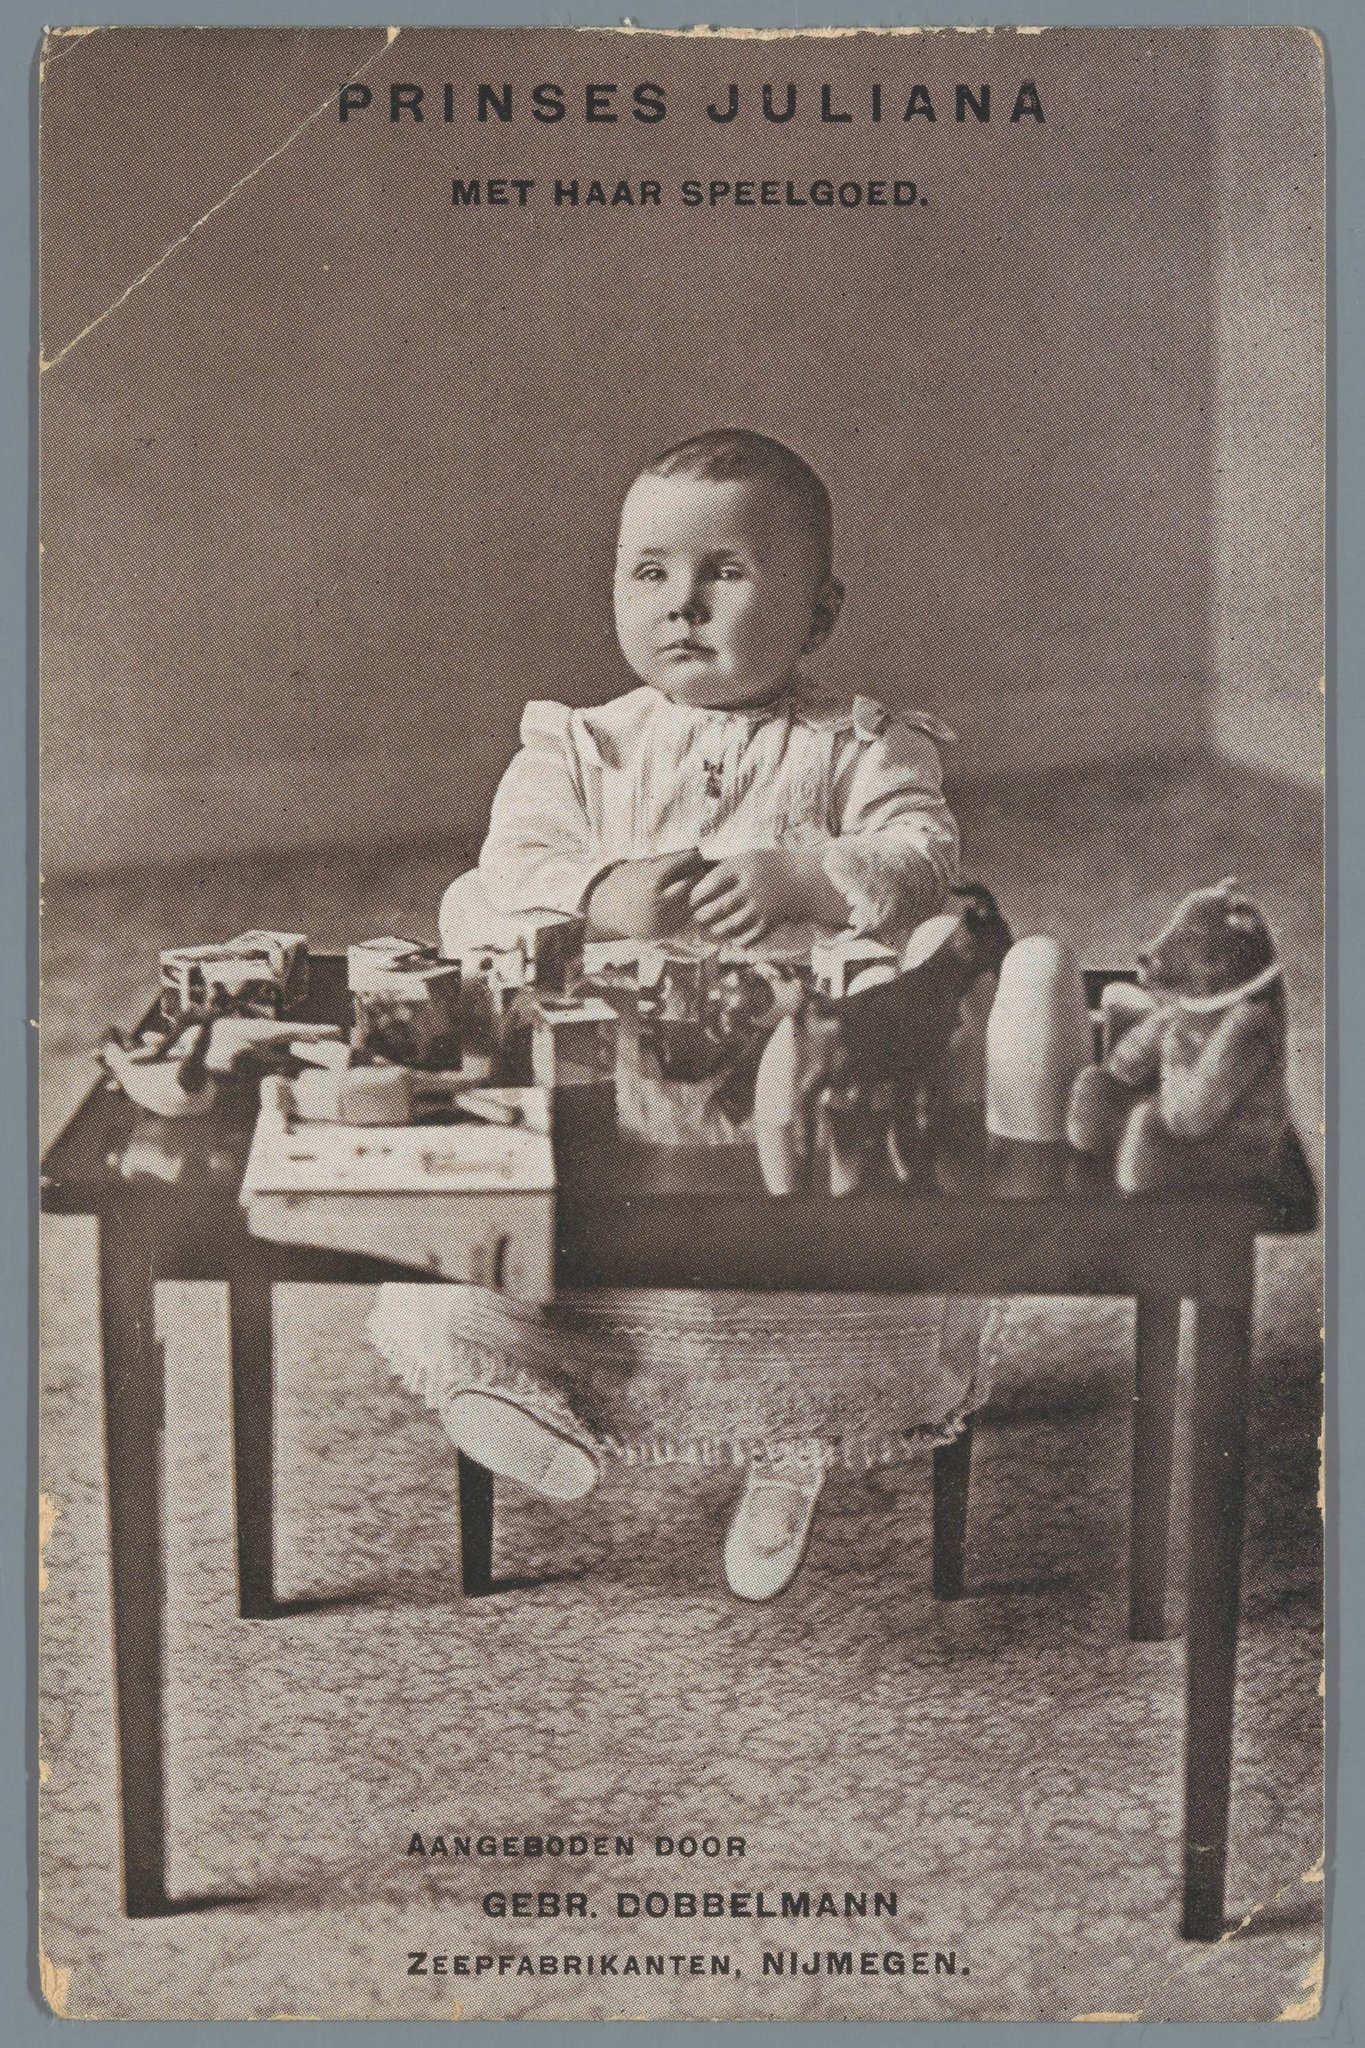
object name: photomechanical print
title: Prinses Juliana met haar speelgoed, aangeboden door Gebr. Dobbelmann, zeepfabrikant, Nijmegen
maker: Anonymous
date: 1911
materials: cardboard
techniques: two-color autotype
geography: netherlands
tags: juliana of the netherlands, crown princess, (playing with) toys